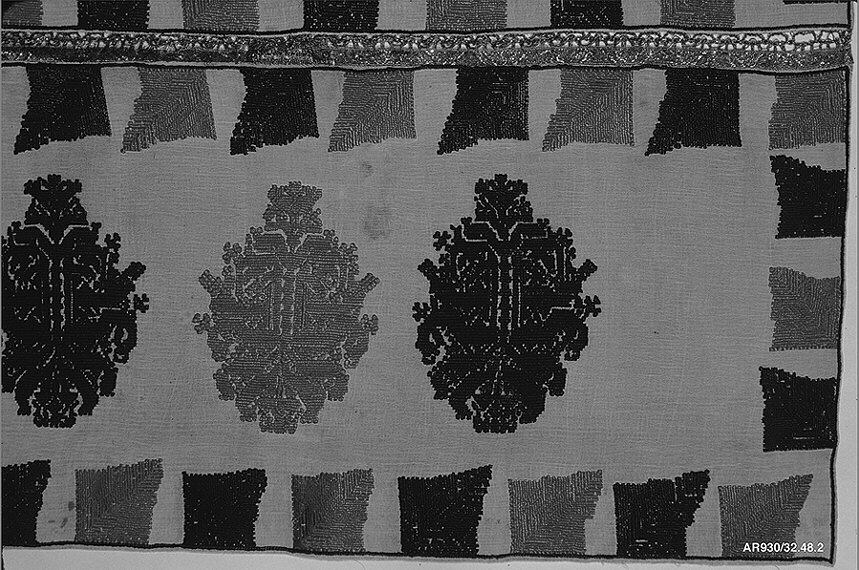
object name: bed hanging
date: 1701-1800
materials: silk